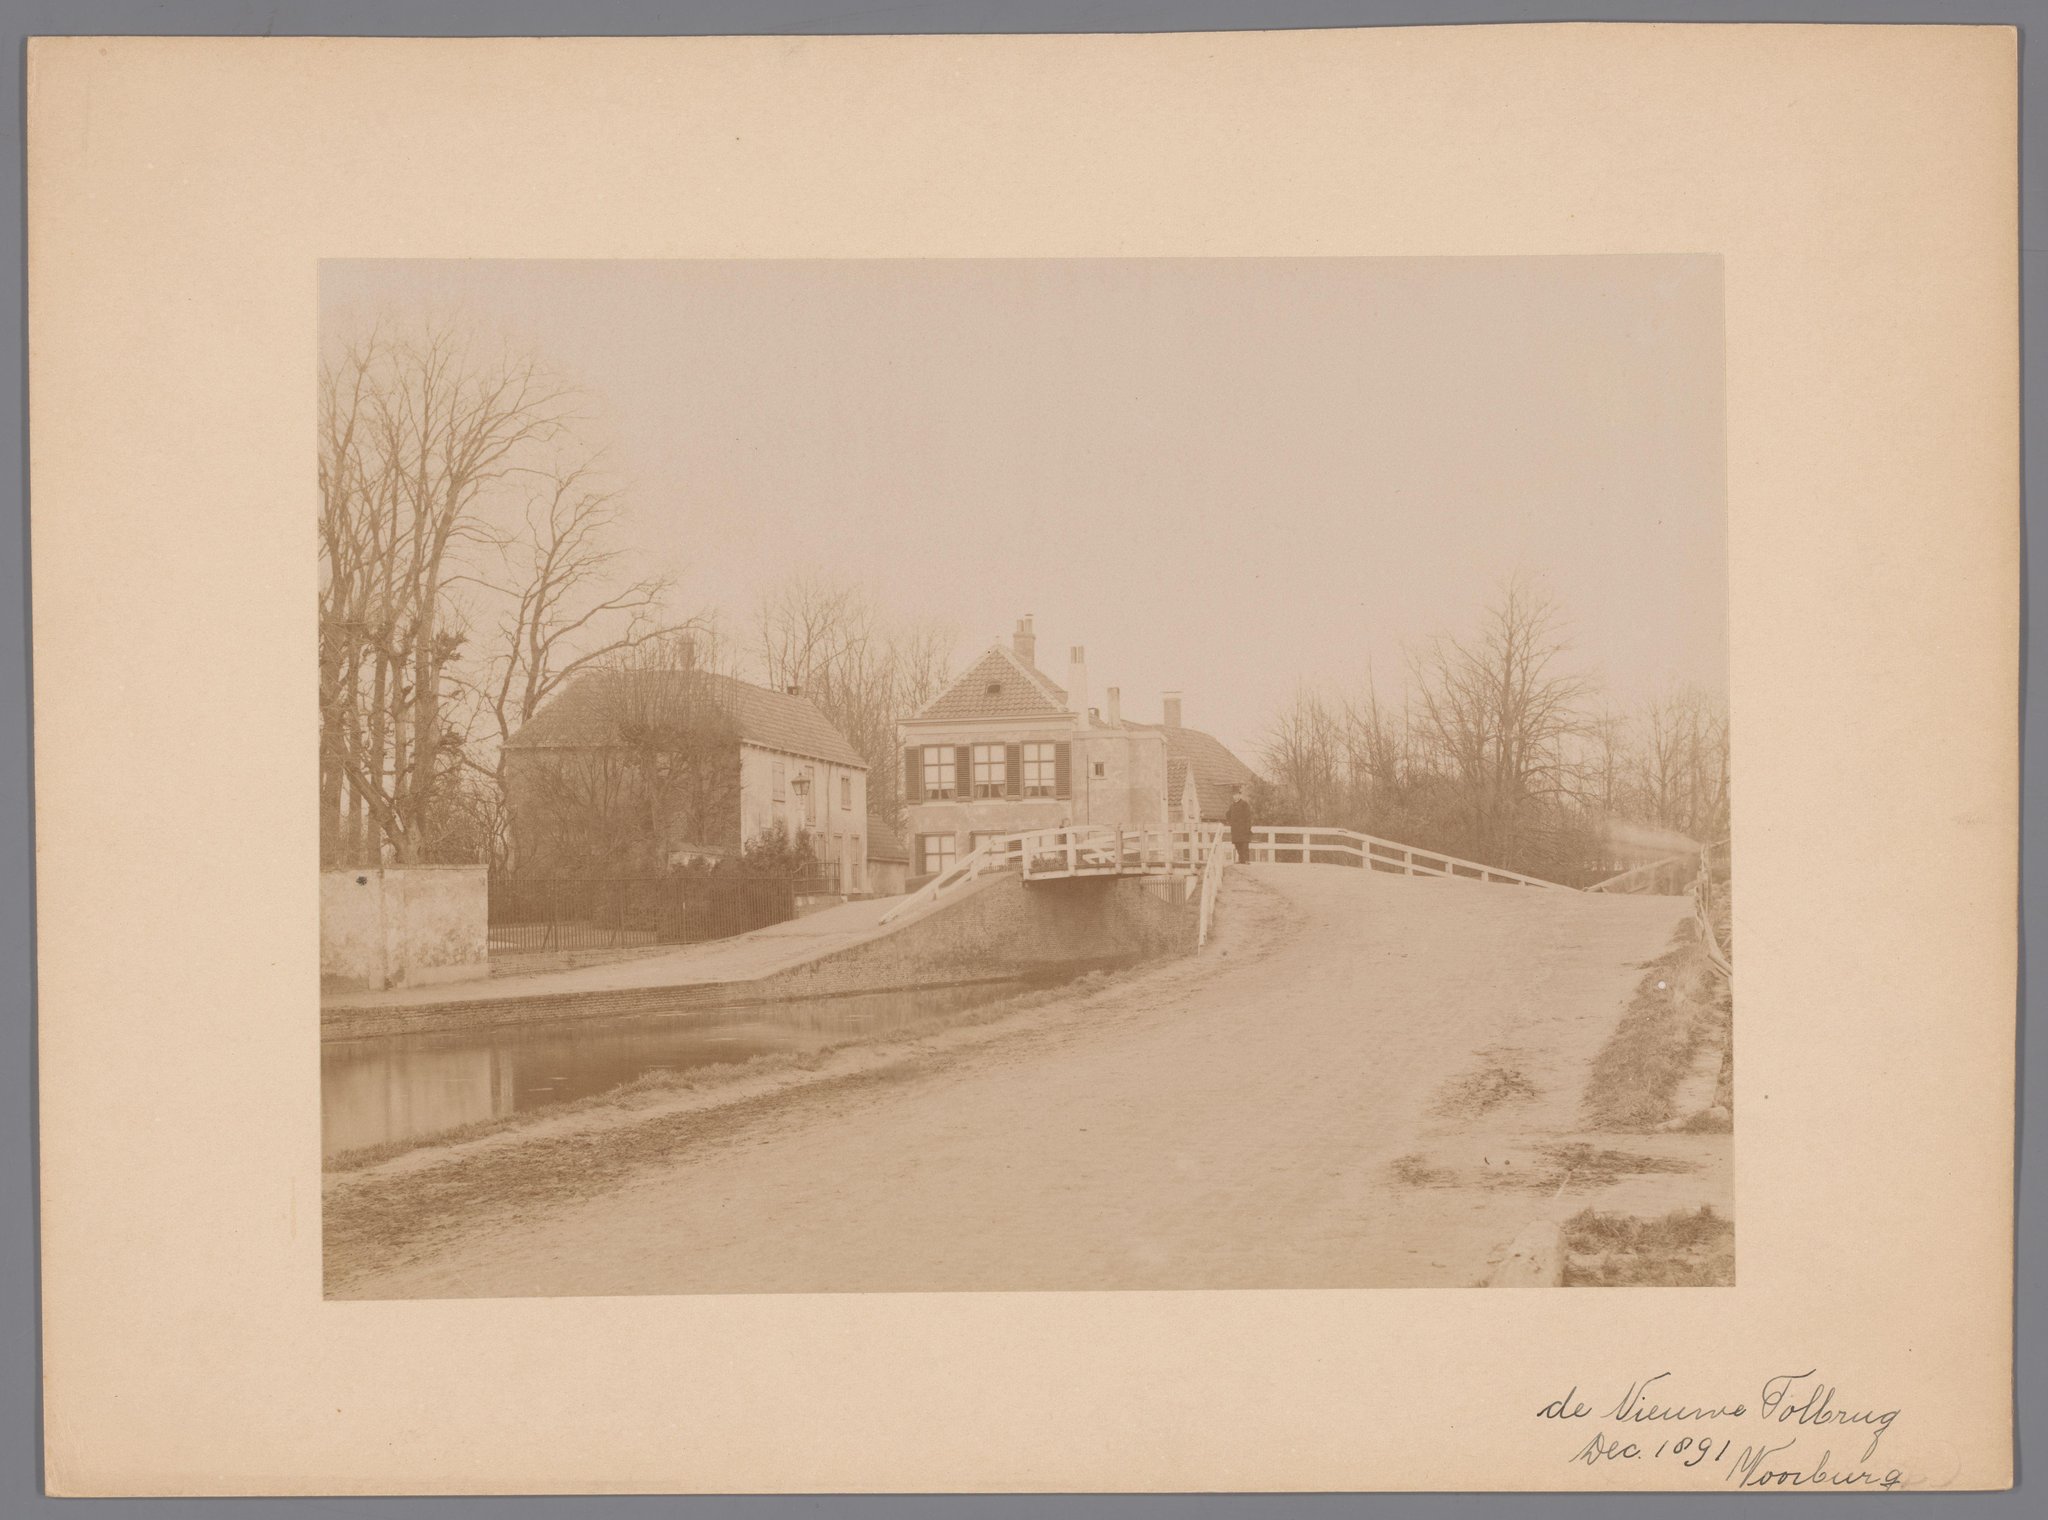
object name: photograph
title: Gezicht op de Nieuwe Tolbrug te Vianen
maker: anoniem (monumentenzorg)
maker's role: fotograaf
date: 1891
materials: cardboard, photographic support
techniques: albumen print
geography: voorburg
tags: bridge in city across river, canal, etc. (+ city(-scape) with figures, staffage), voorburg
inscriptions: annotation: ‘De nieuwe tolbrug te Voorburg b/d Haag/ Dec. 1891’, annotation: ‘de Nieuwe Tolbrug/ Dec. 1891/ Voorburg’